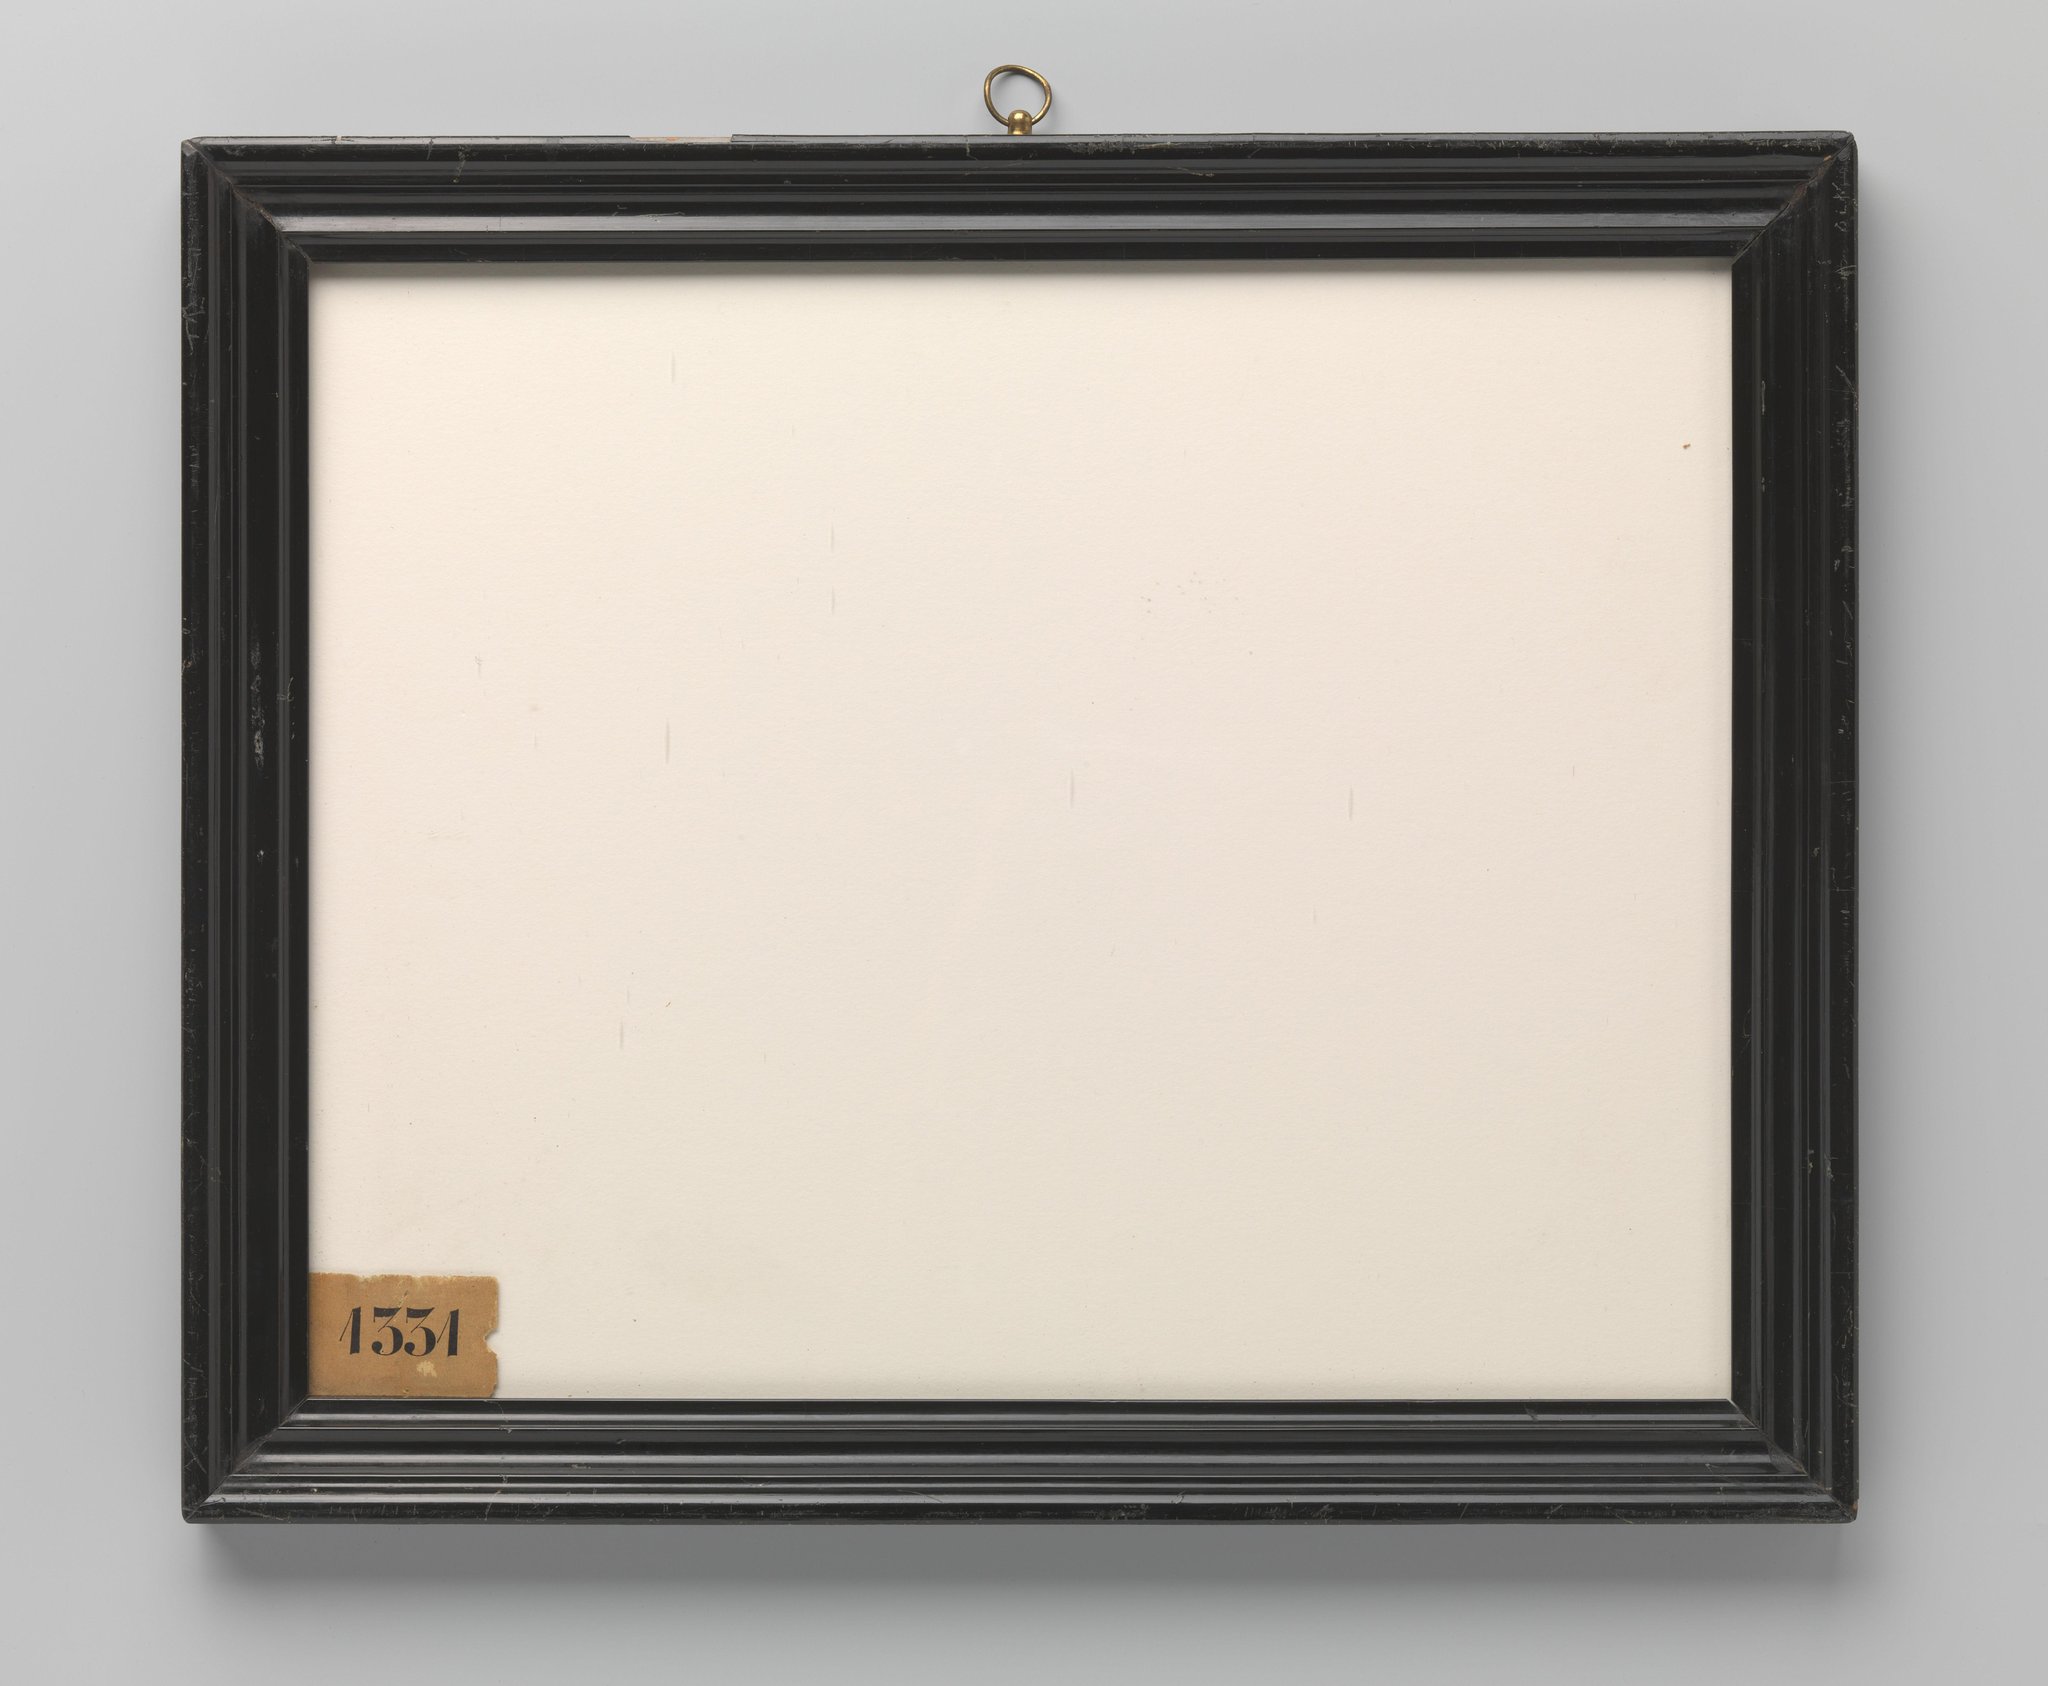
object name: frame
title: Picture Frame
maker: Anonymous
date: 1800-1883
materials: cardboard, glass, wood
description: Lijst behorend bij een foto van een schroefstoomschip 4de klasse in een kanaal.